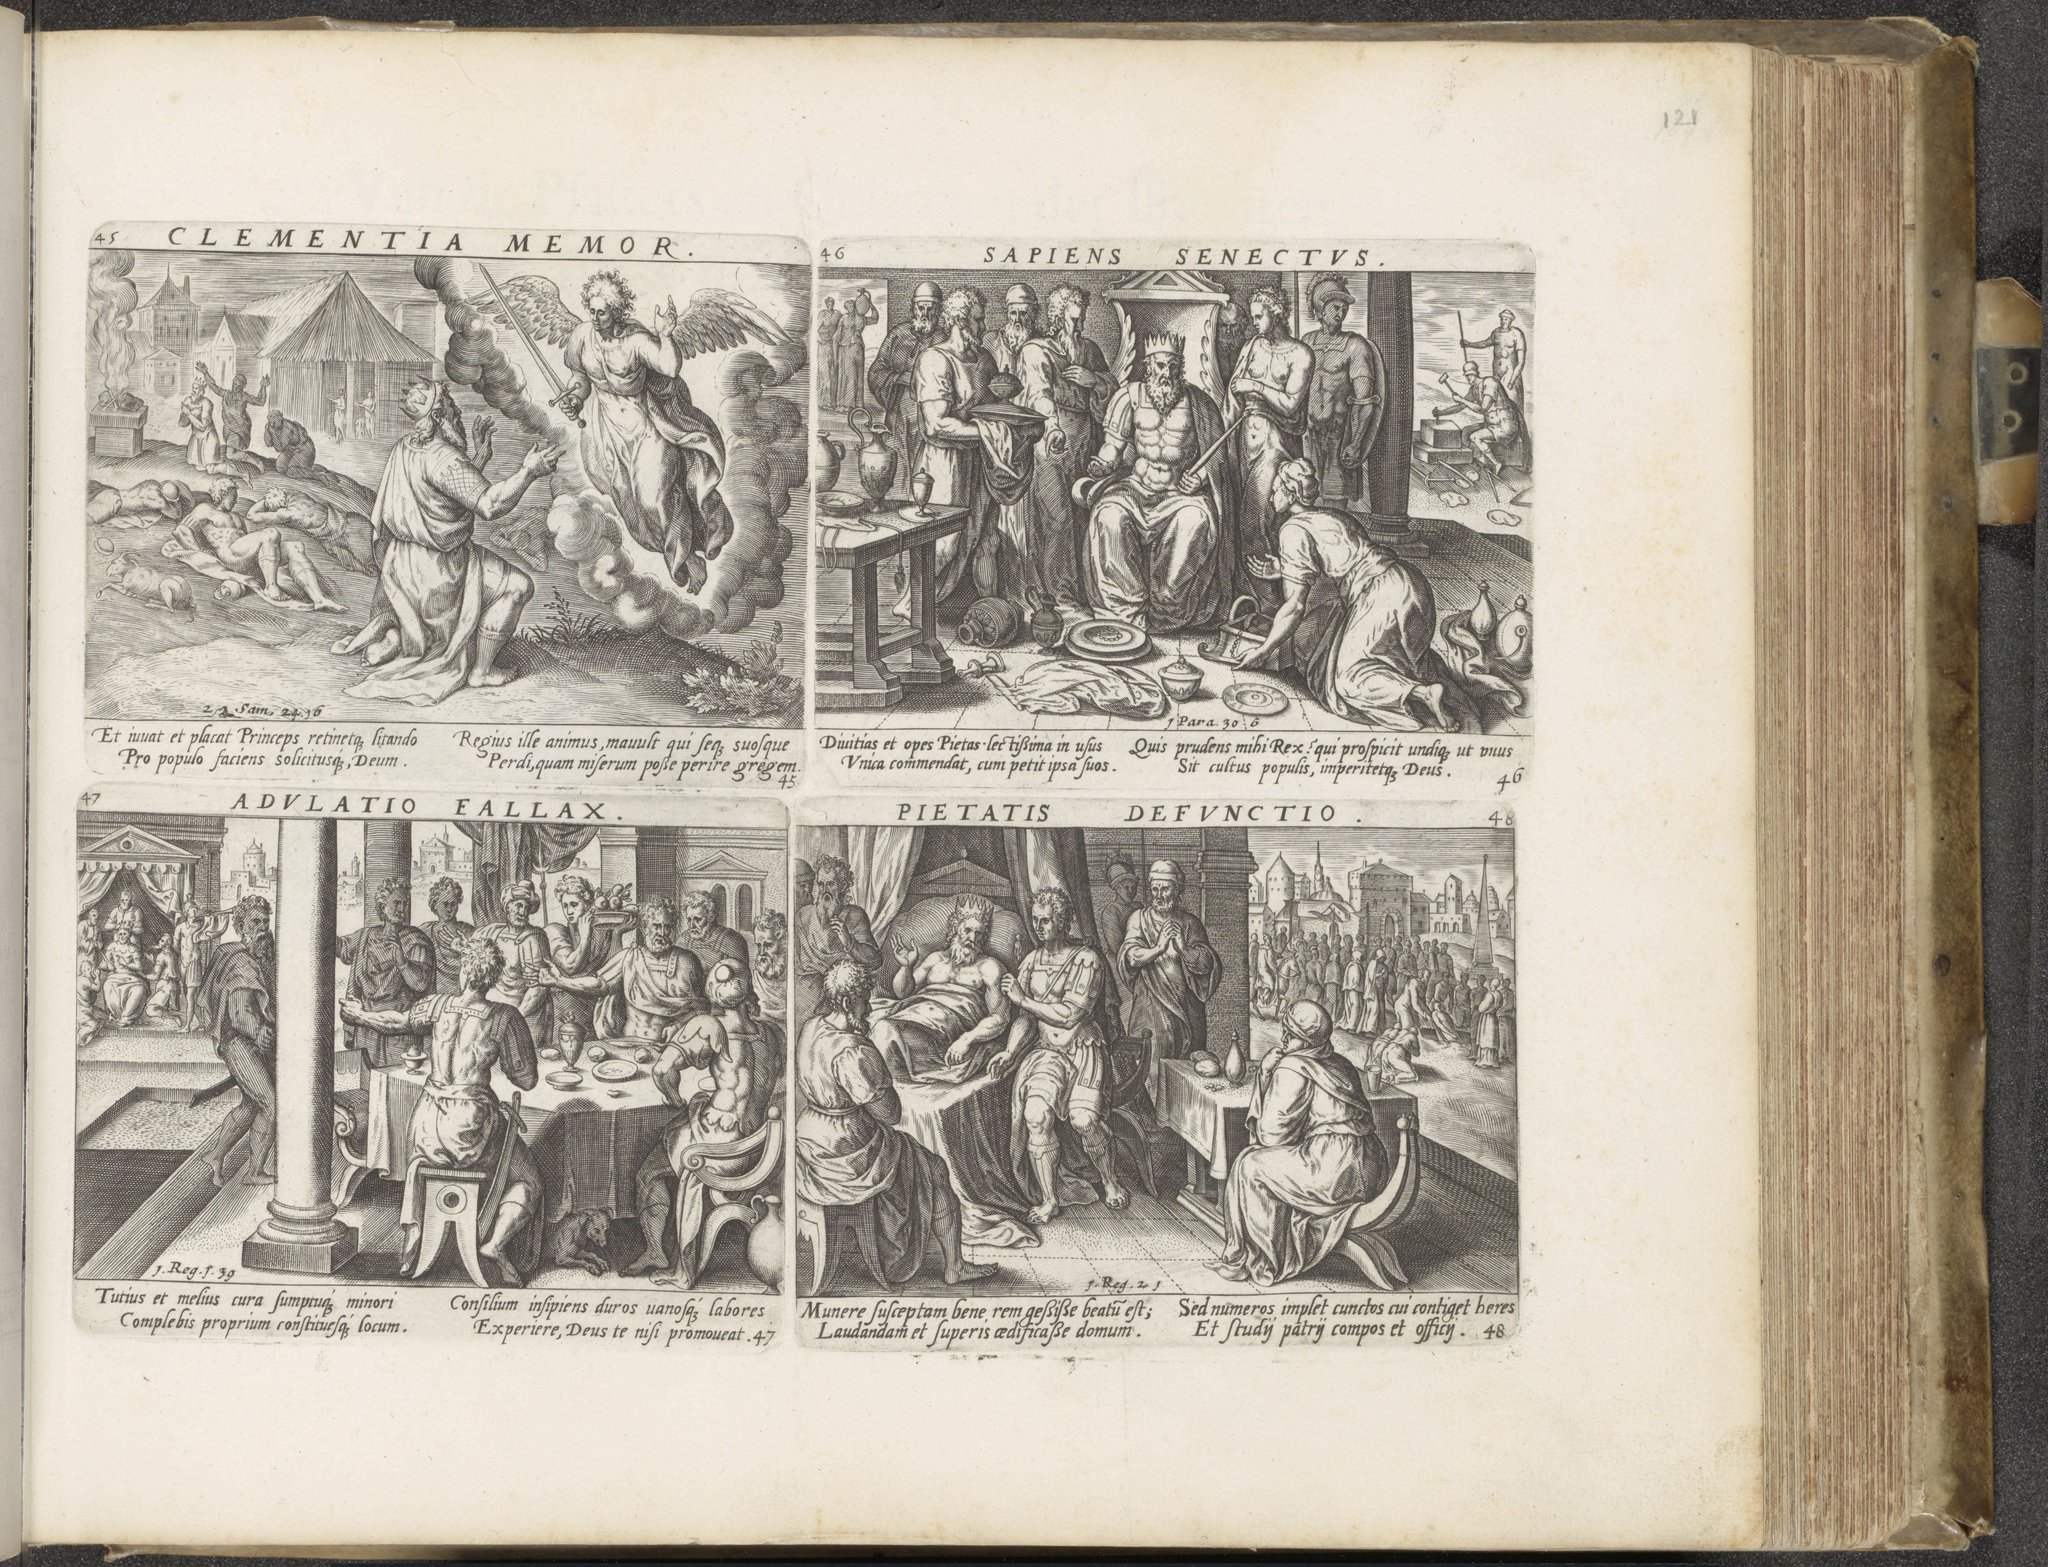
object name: album leaf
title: Den Grooten Emblemata Sacra, bestaande in meer dan vier hondert bybelsche figuren, zoo des Ouden als des Nieuwen Testaments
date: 1575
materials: paper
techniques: engraving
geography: amsterdam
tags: david exhorts the elders to help solomon to build the temple, adoniah constitutes himself as king, david proclaims solomon king, adoniah is told of solomon's kingship by abiathar's son jonathan, david's death, david's burial, story of david, david sees the avenging angel in jerusalem; he prays to god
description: Vier voorstellingen op een albumblad over het leven van David, genummerd 45 tot en met 48. Linksboven de verschijning van de wrekende engel Gods aan koning David. Rechtsboven ontvangt David geschenken voor de bouw van de tempel. Linksonder zitten gasten bij Adonia aan tafel die zichzelf als koning opwerpt. Op de achtergrond wordt Salomo tot koning gekroond. Rechtsonder de stervende David met rechts op de achtergrond zijn begrafenis. Het blad maakt deel uit van een album.